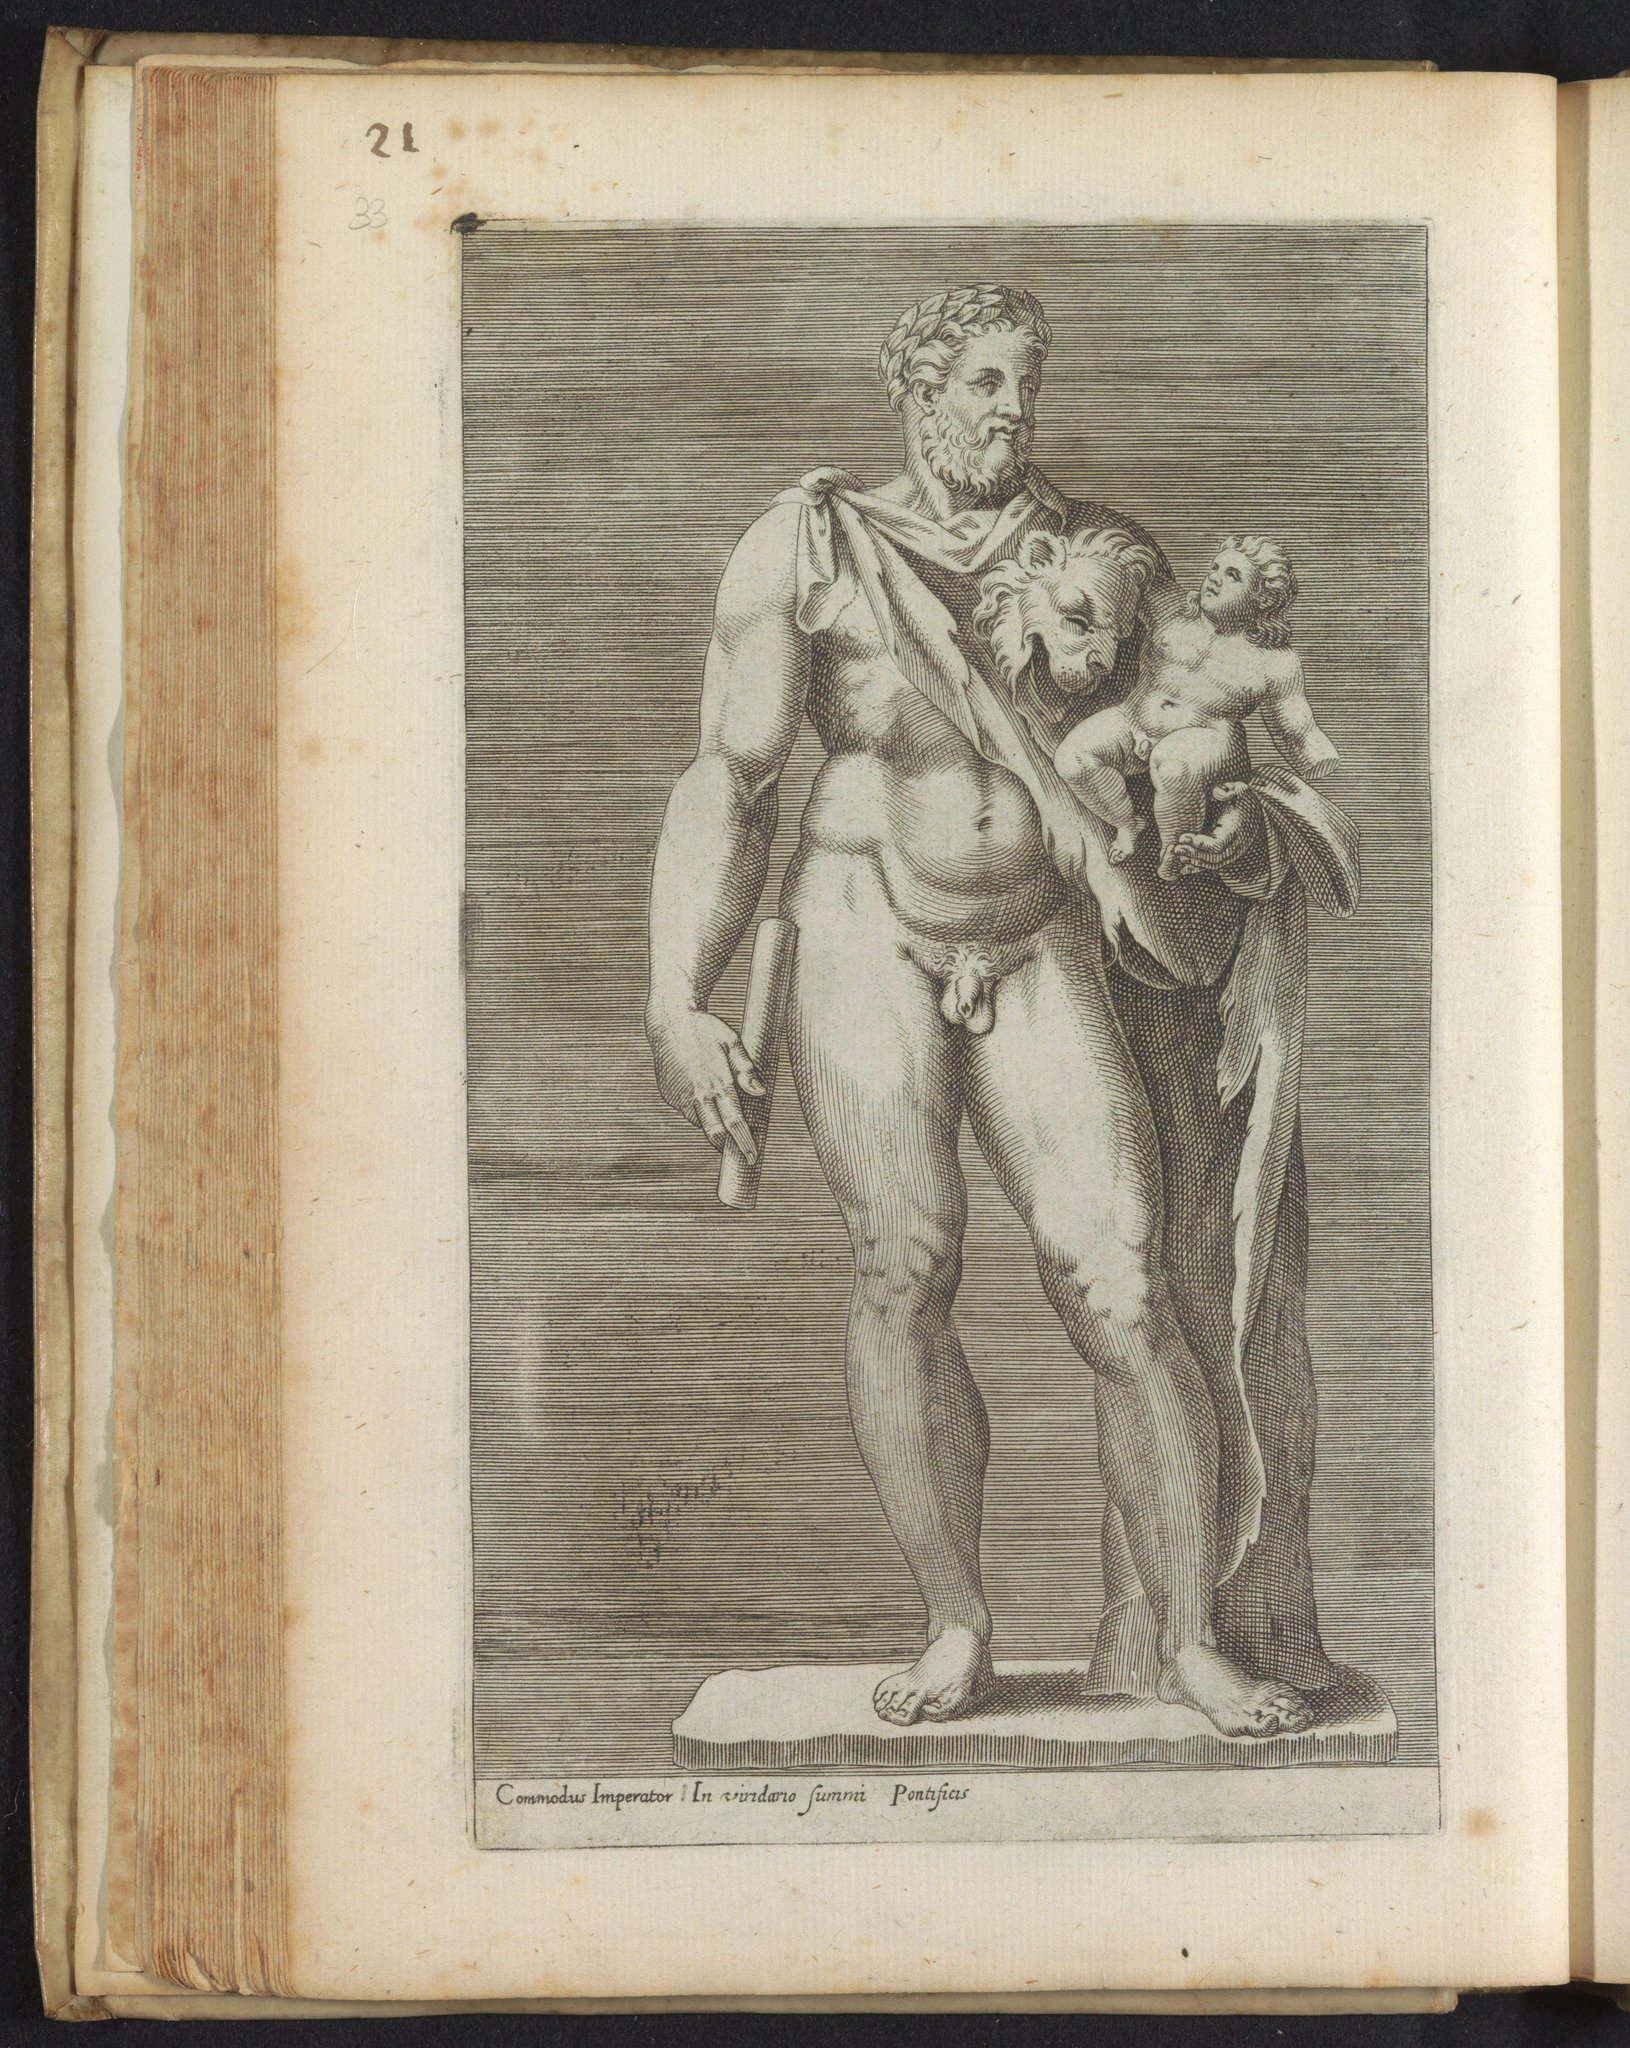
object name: album leaf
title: Antiquarum statuarum urbis Romae quae in publicis locis visuntur icones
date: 1584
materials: paper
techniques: engraving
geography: rome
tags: (story of) hercules (heracles), portrait of emperor commodus, piece of sculpture, reproduction of a piece of sculpture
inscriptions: number: ‘21’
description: Deze prent maakt deel uit van een set van 79 prenten (+ titelprent) met voorstellingen van antieke sculpturen in Rome.